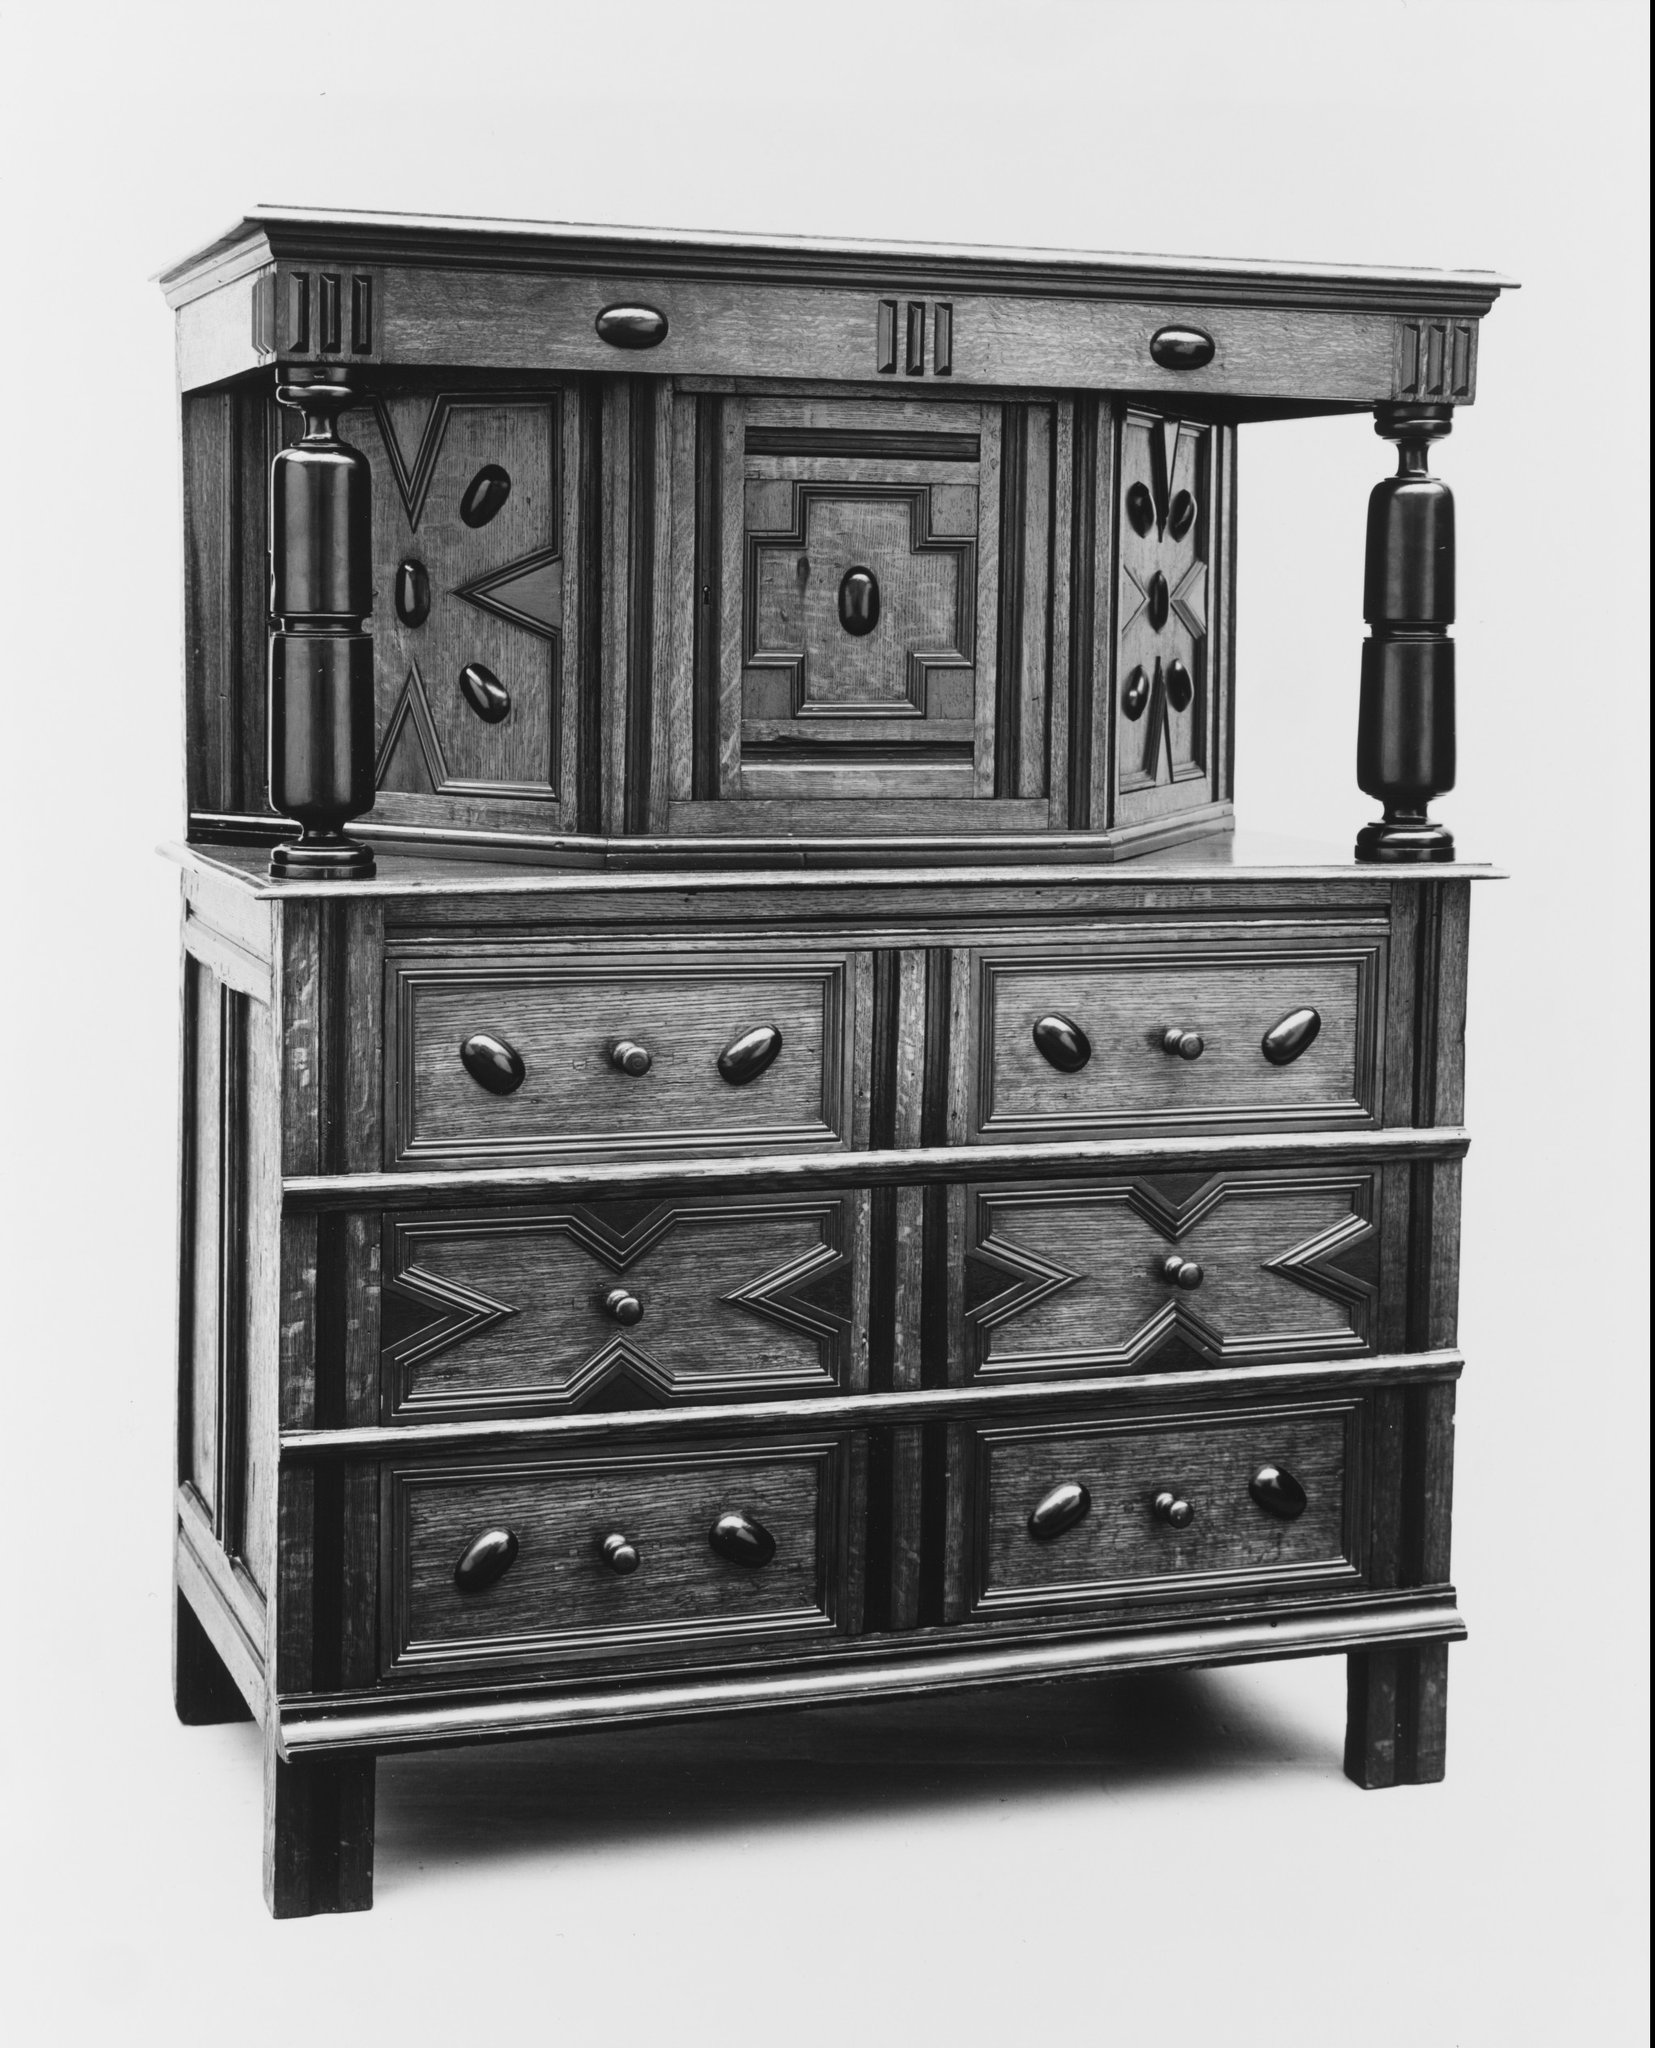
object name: cupboard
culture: american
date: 1675-1700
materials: wood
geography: united states